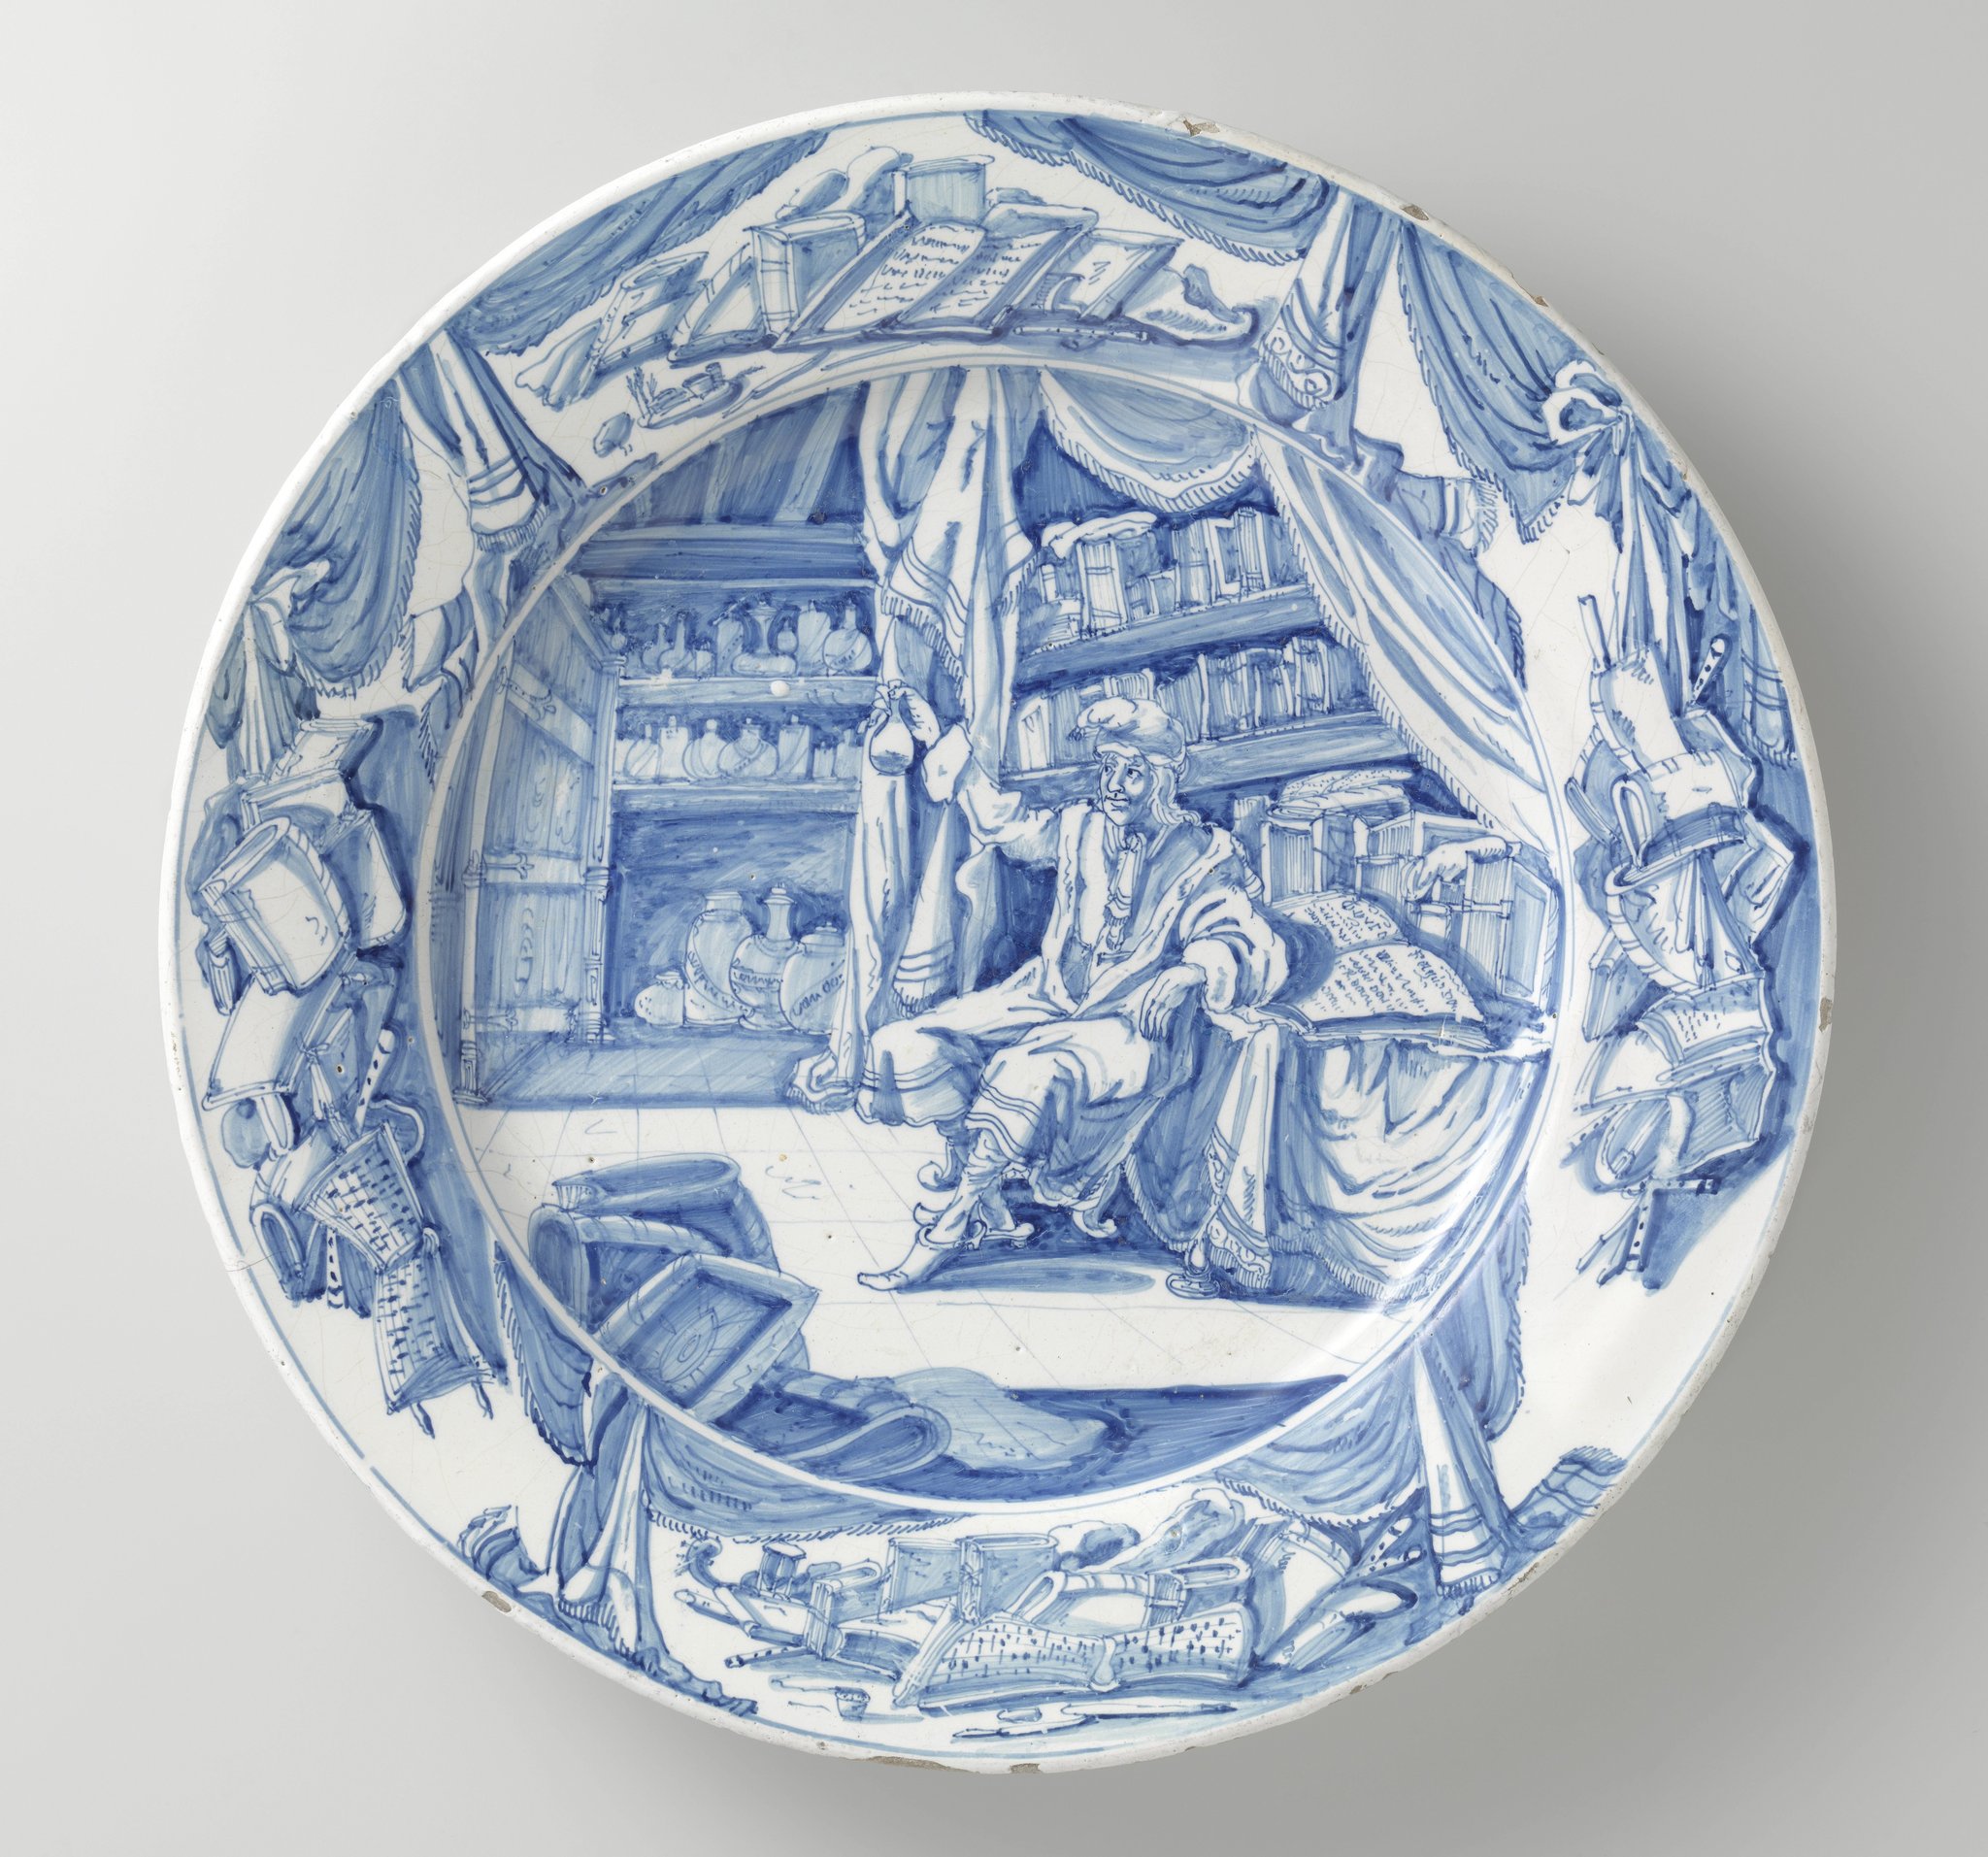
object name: platter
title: Dish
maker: willem jansz. verstraeten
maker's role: plateelbakker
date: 1645-1660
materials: faience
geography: haarlem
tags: pharmacist, druggist, apothecary; pharmacy, drugstore, dispensing chemist, physician, doctor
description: Schotel van faience met een geneesheer in zijn studeervertrek